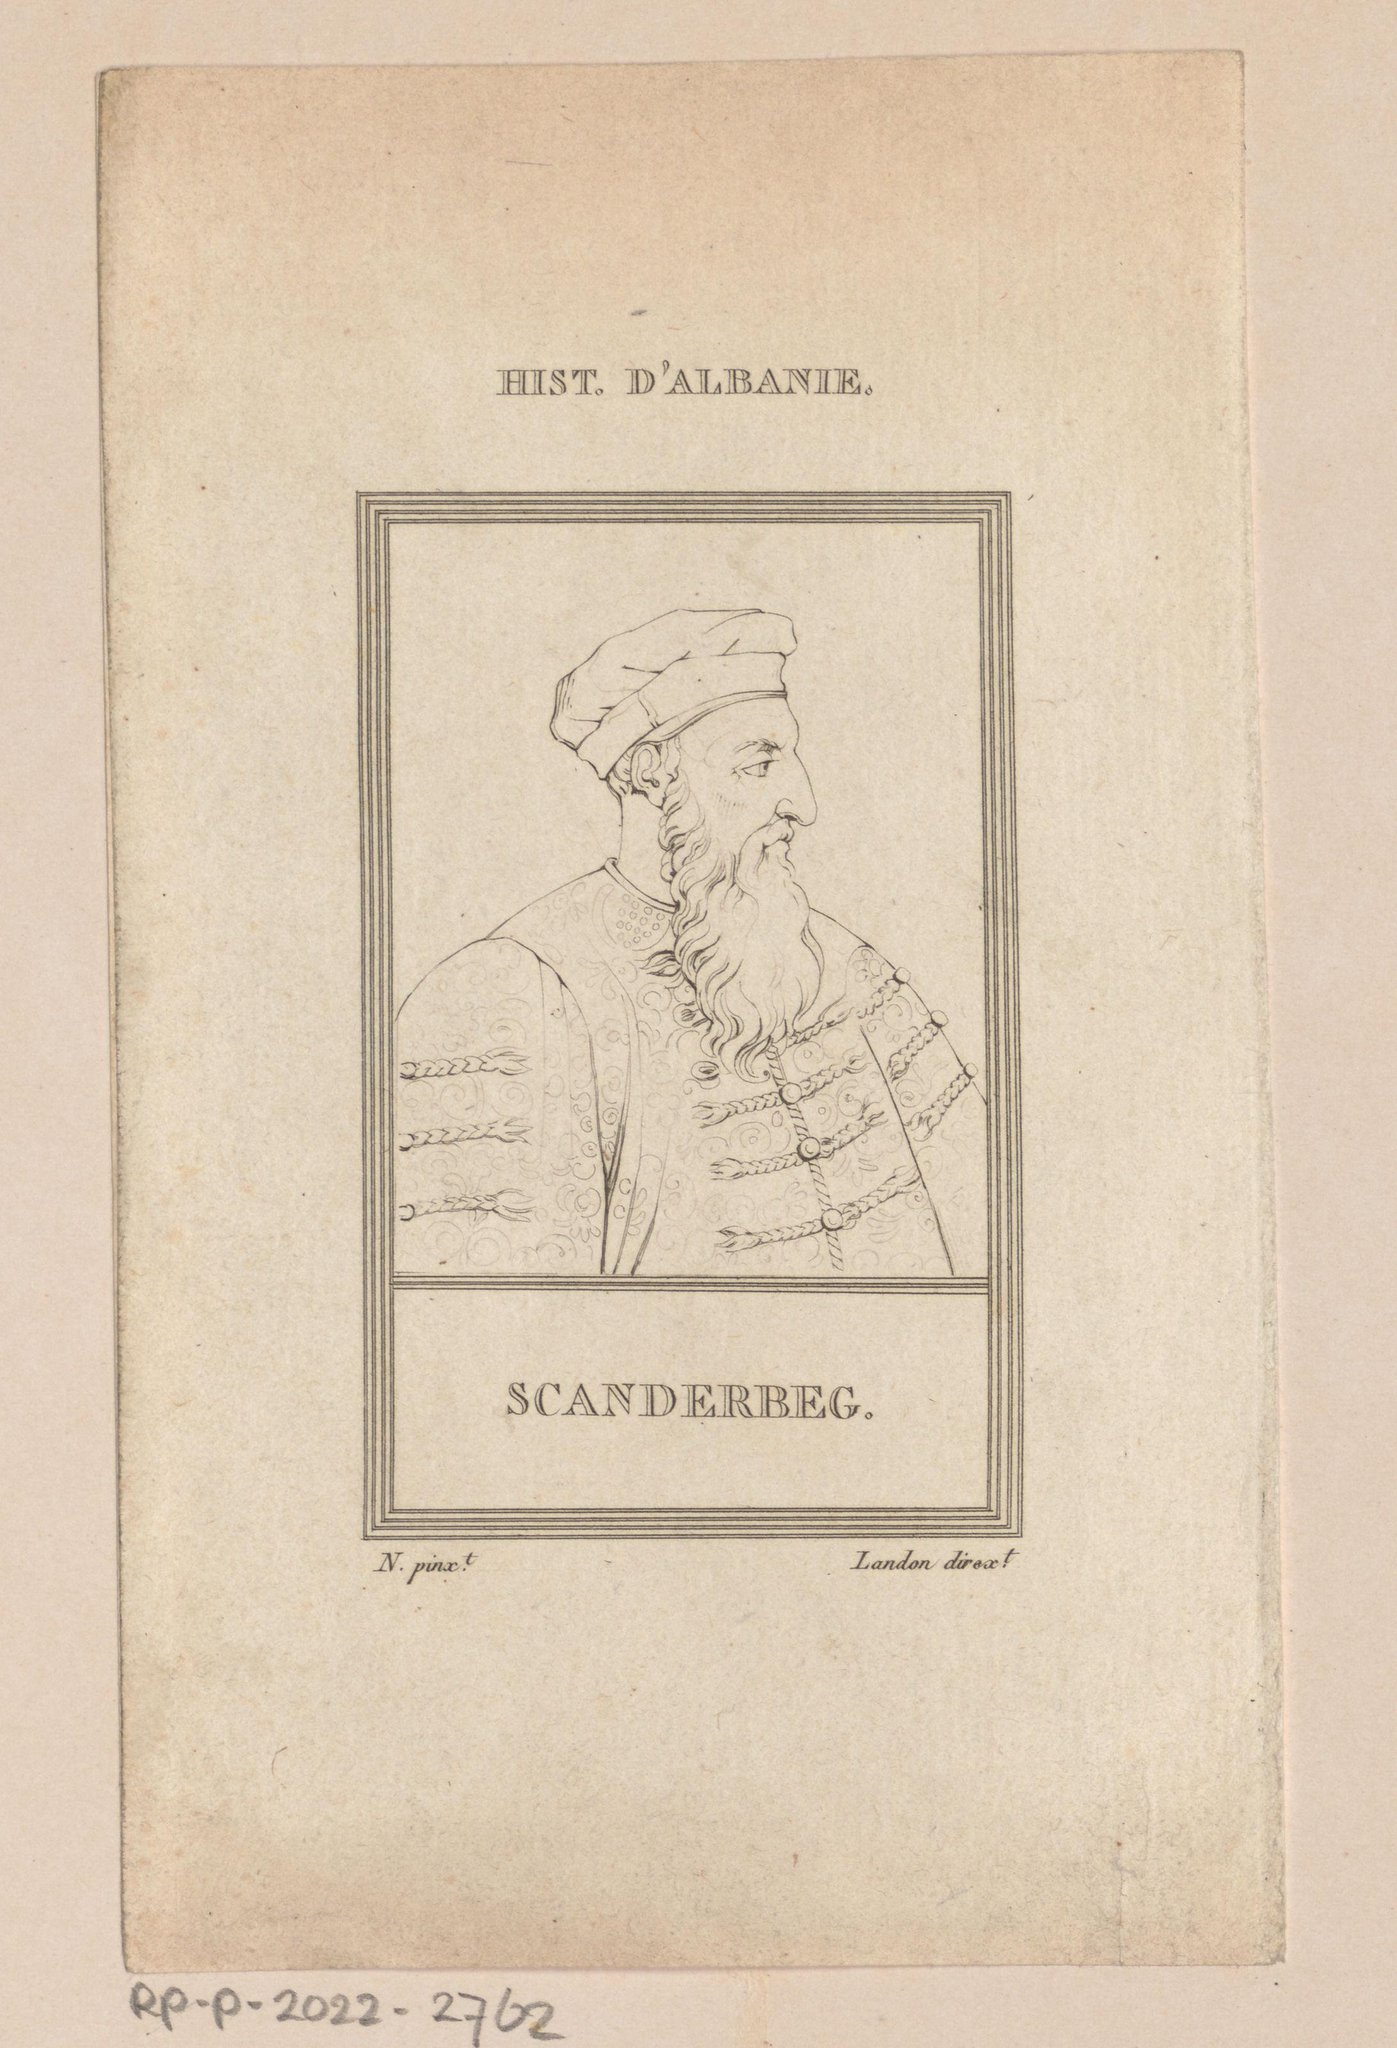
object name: print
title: Portret van Skanderbeg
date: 1806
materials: paper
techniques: etching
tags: commander-in-chief, general, marshal, historical persons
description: Prent waarschijnlijk uit: Landon, Charles Paul. Galerie historique des hommes les plus célèbres (...). Parijs: Imprimerie des Annales du Musée, 1806, dl. 7.